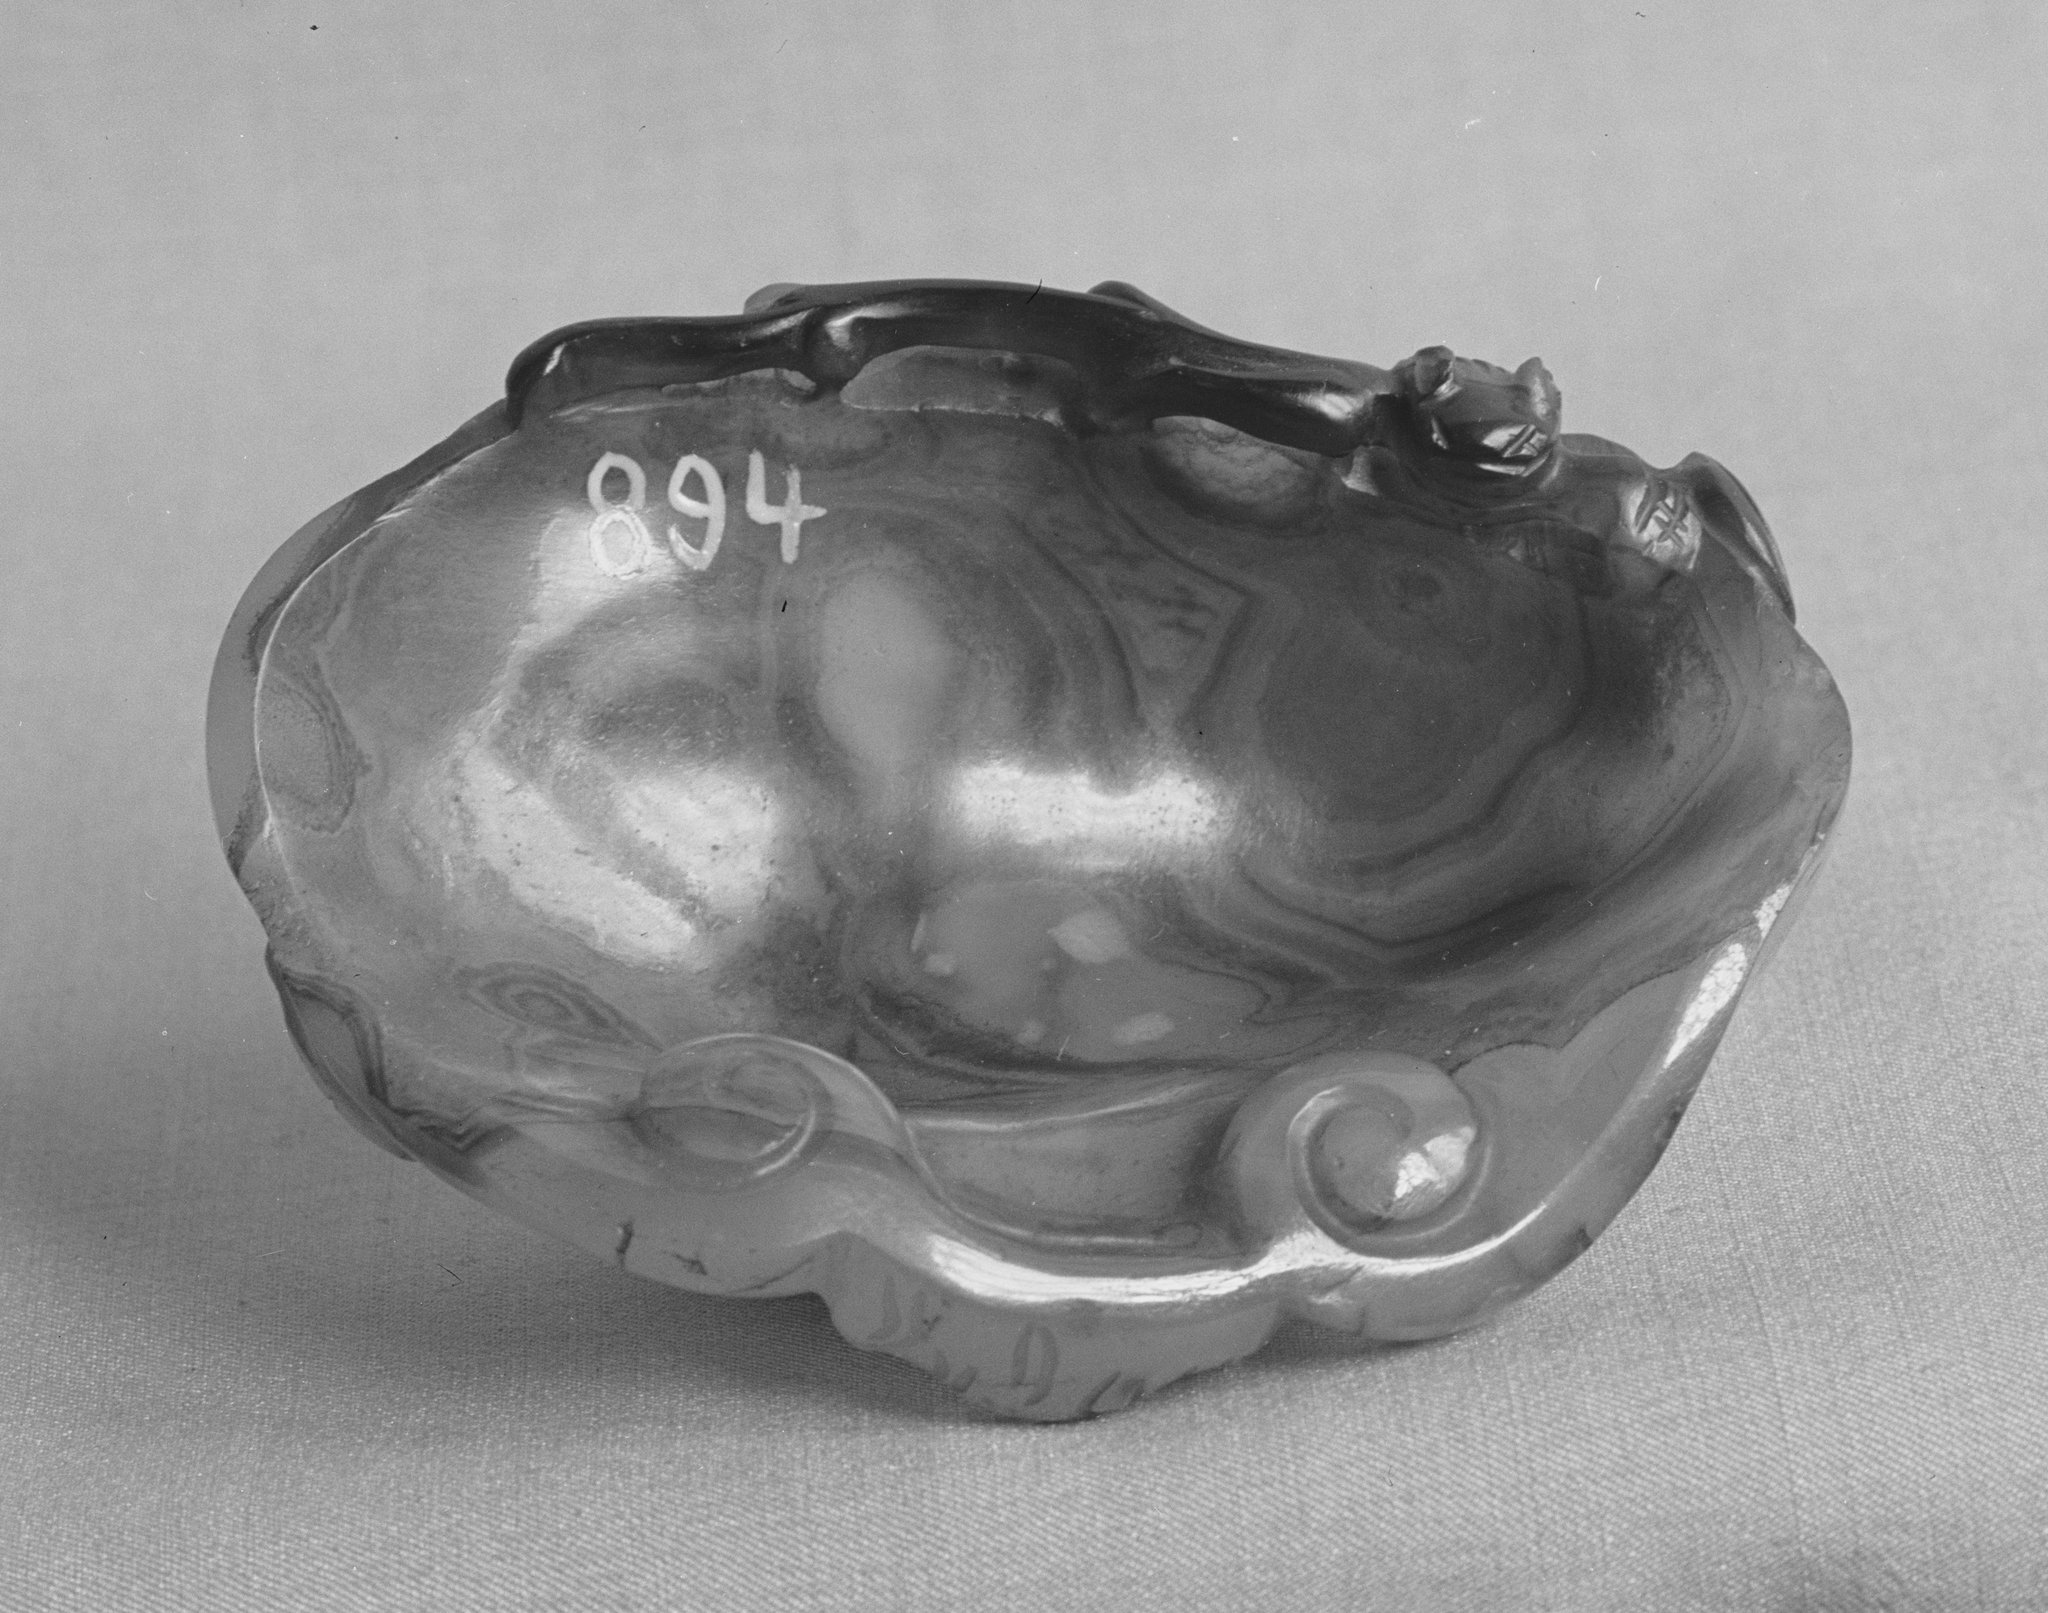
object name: dish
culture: chinese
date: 1701-1800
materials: stone